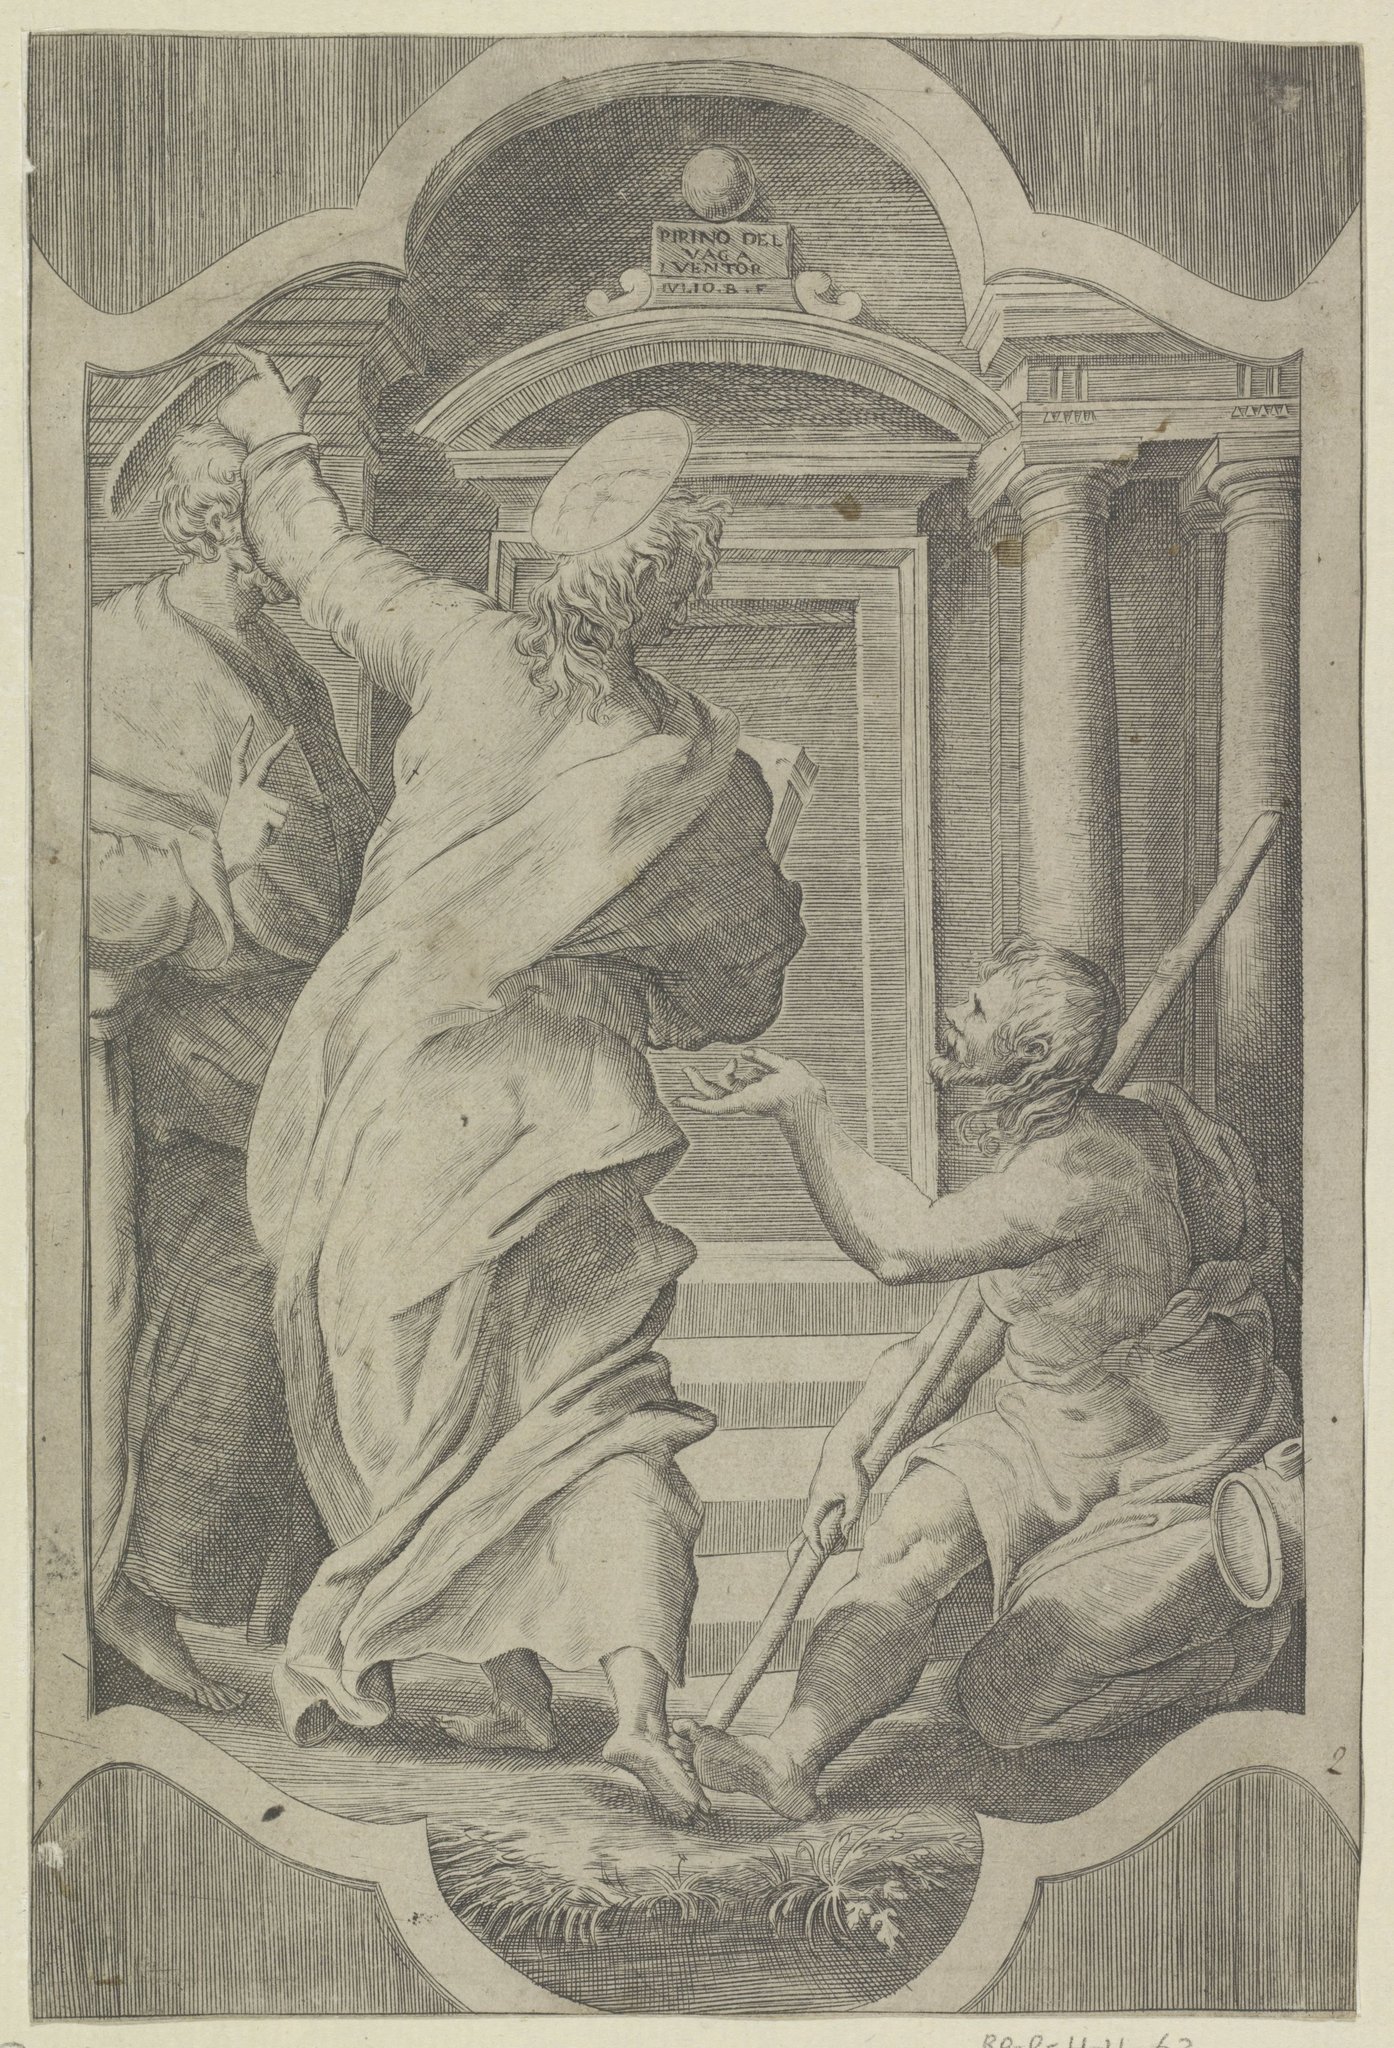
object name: print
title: Petrus en Johannes genezen een verlamde man bij de tempelpoort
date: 1501-1580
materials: paper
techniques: engraving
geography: italy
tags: healing of a lame beggar at the beautiful gate of the temple by peter and john (acts 3 - 4:31), disabilities, deformations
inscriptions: collector's mark: ‘Hinloopen’, collector's mark: Lugt 11, collector's mark: Lugt 10, number: ‘2’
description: De voorstelling is gebaseerd op de tekst uit Handelingen 3:4-31. De heilige Petrus en Johannes de Evangelist genezen een verlamde man die voor een tempelpoort zit. Johannes op de rug gezien.